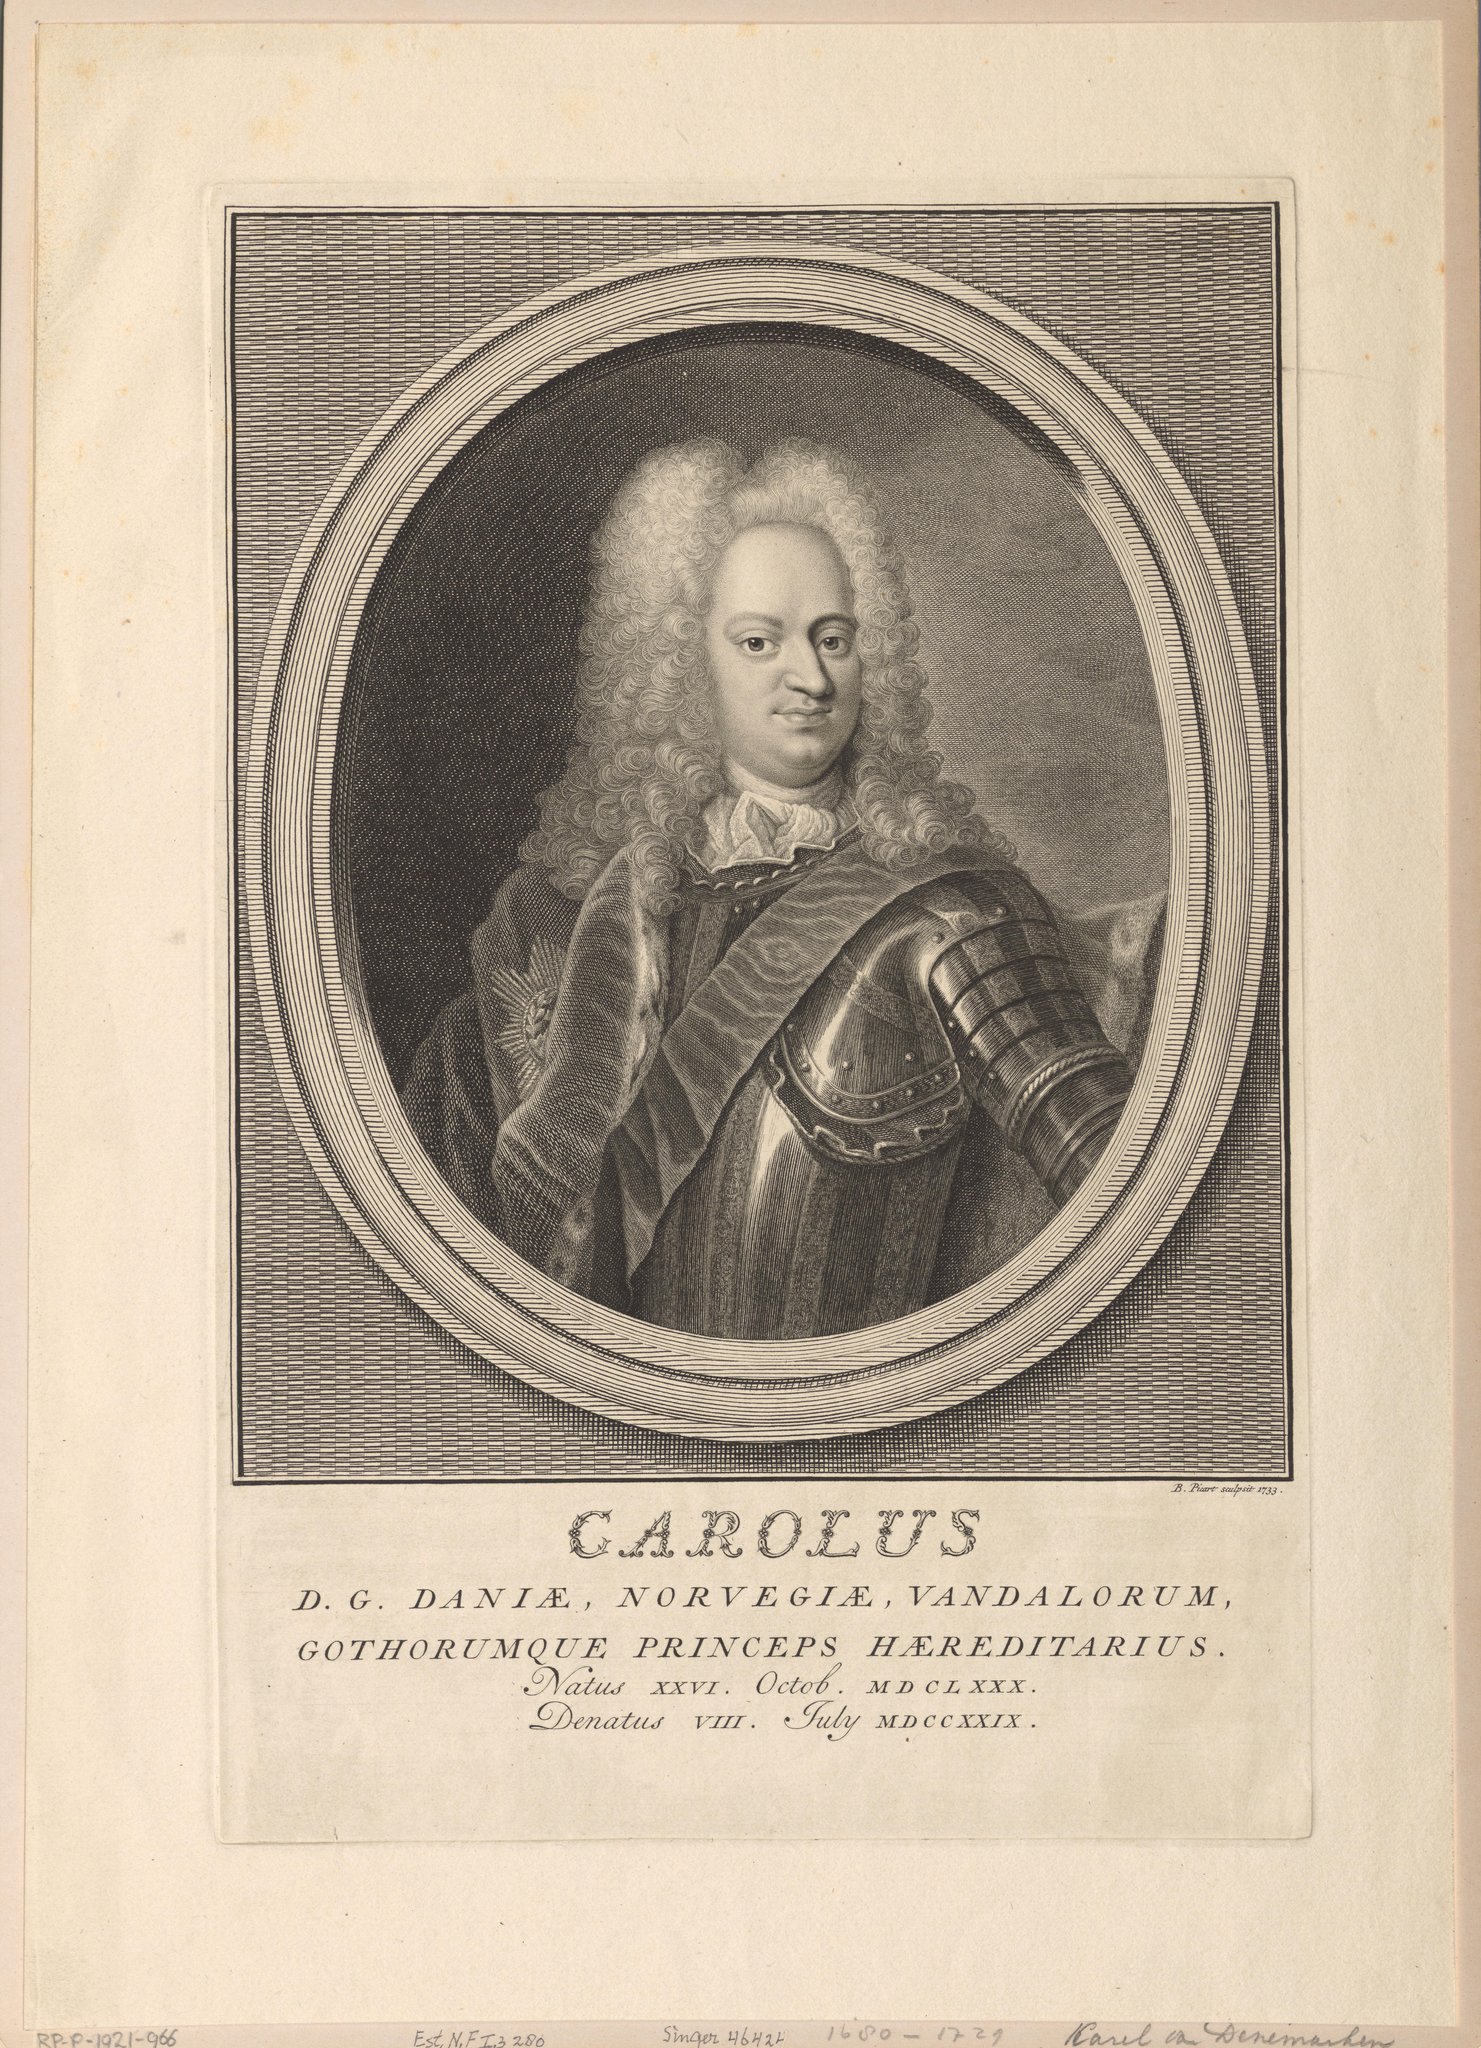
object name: print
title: Portret van Karel, prins van Denemarken en Noorwegen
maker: bernard picart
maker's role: draughtsman, print maker, publisher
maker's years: 1673-1733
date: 1733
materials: paper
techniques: engraving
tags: historical persons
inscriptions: collector's mark: Lugt 2228